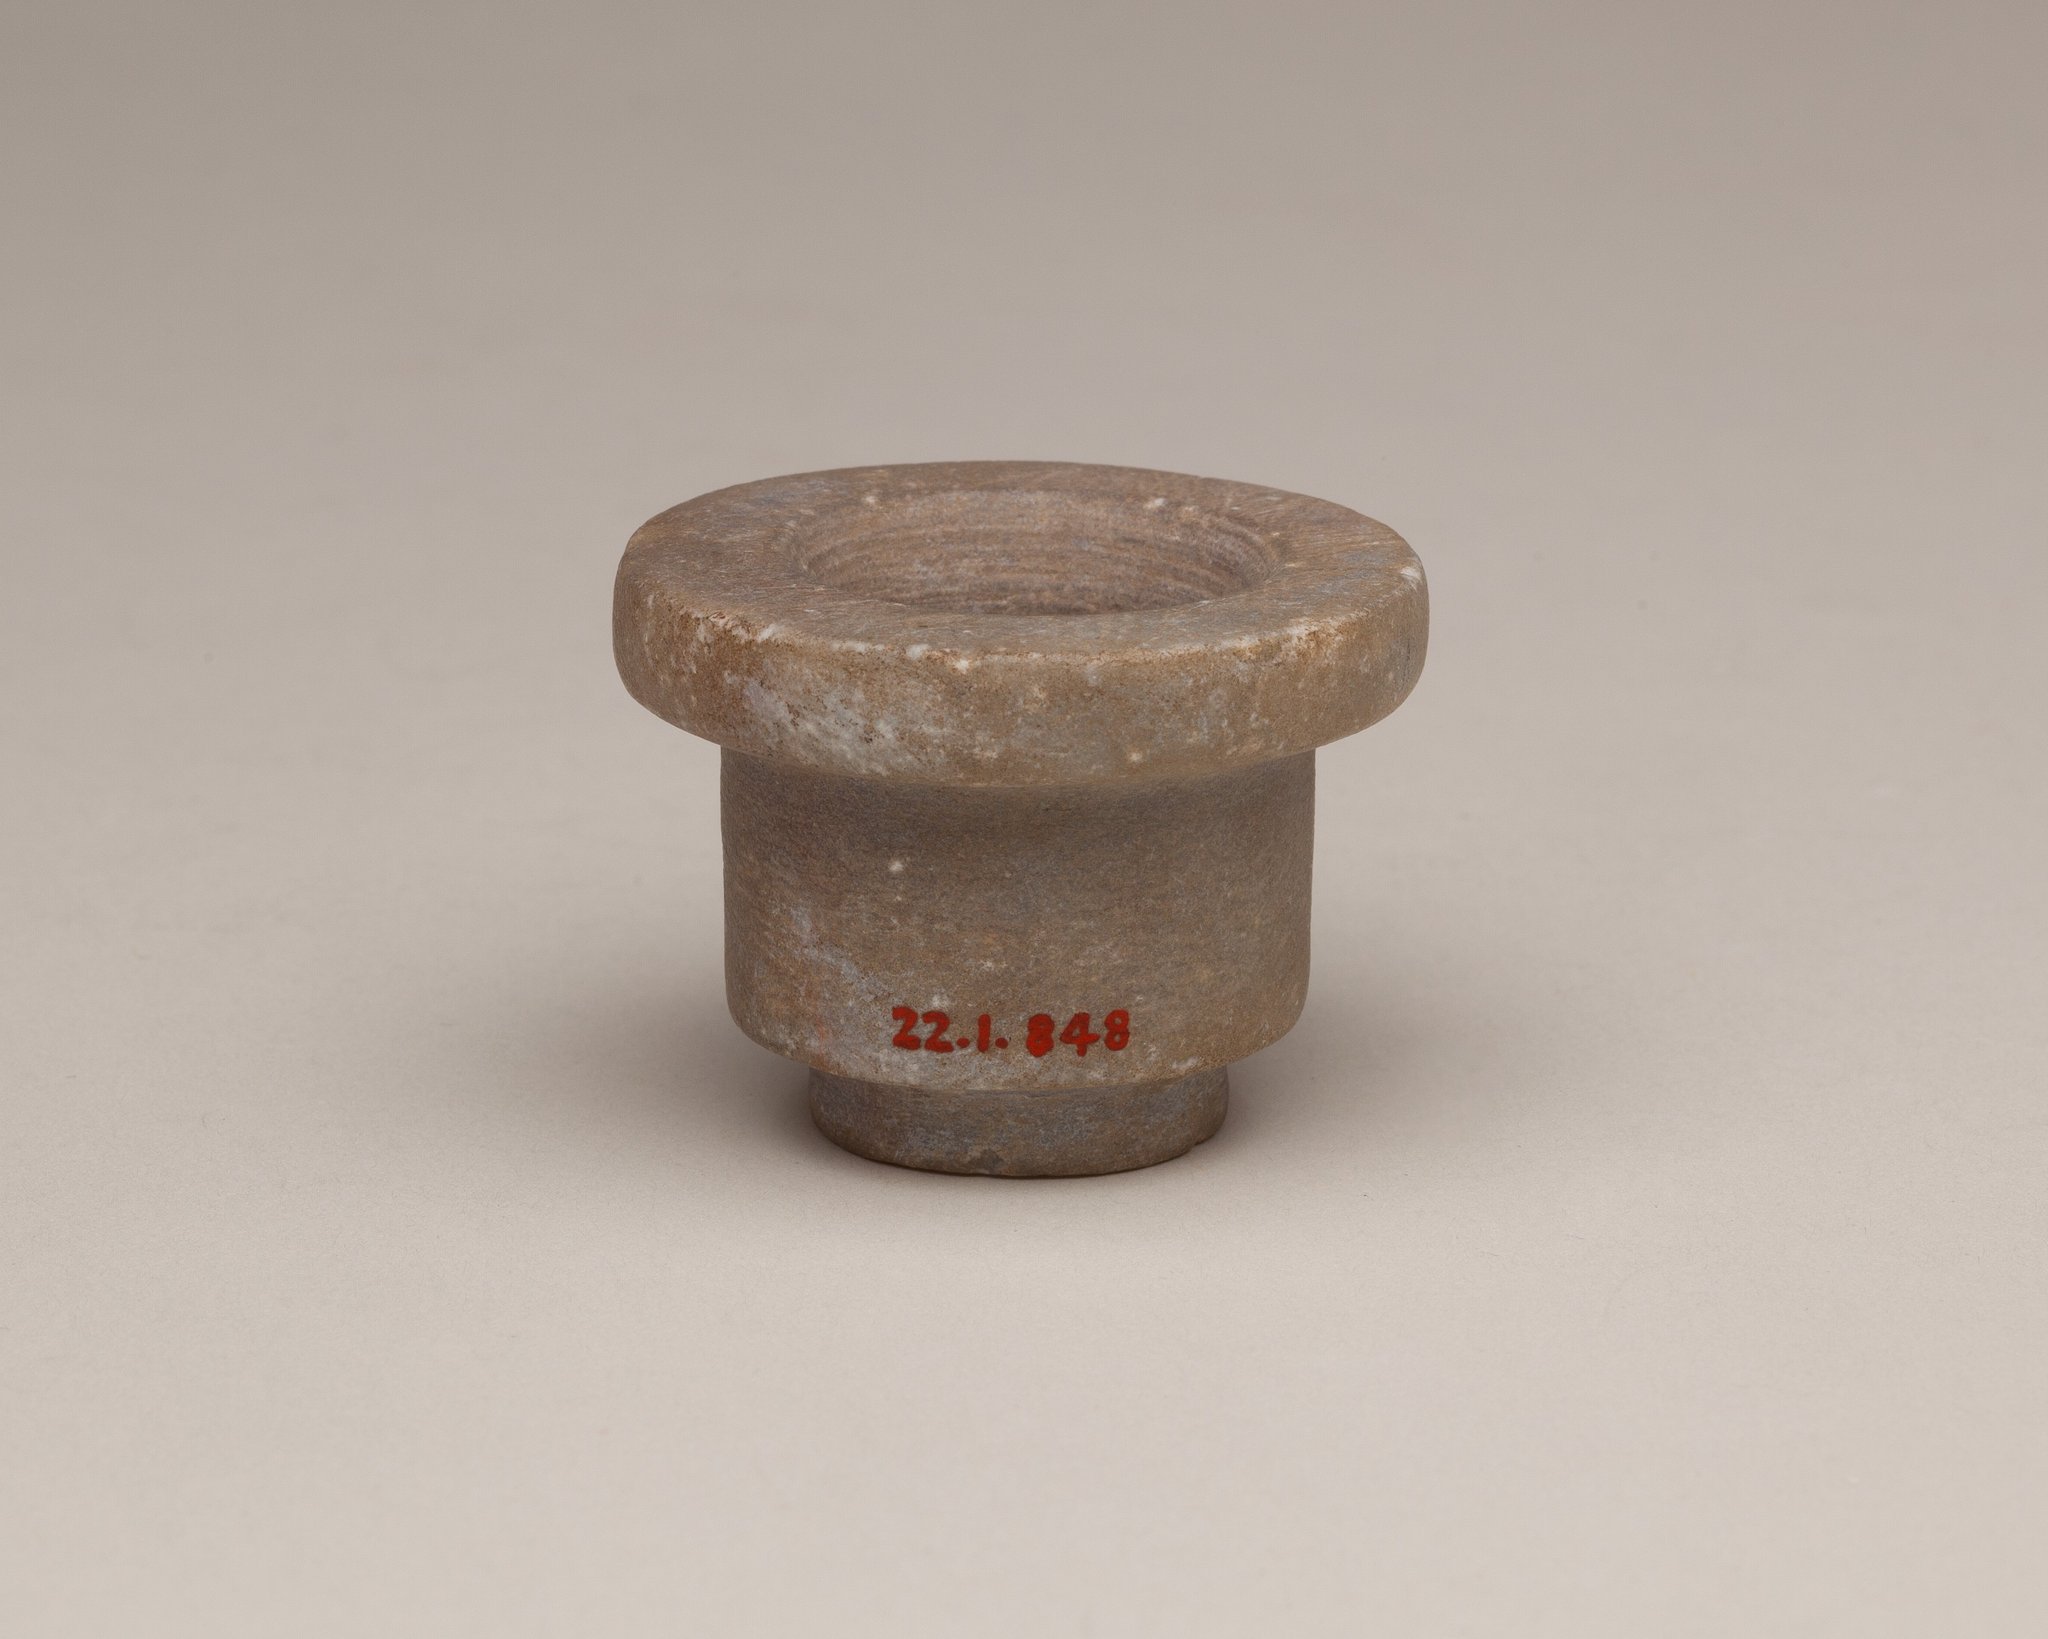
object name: neck of jar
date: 1981-1640 BCE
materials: marble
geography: egypt